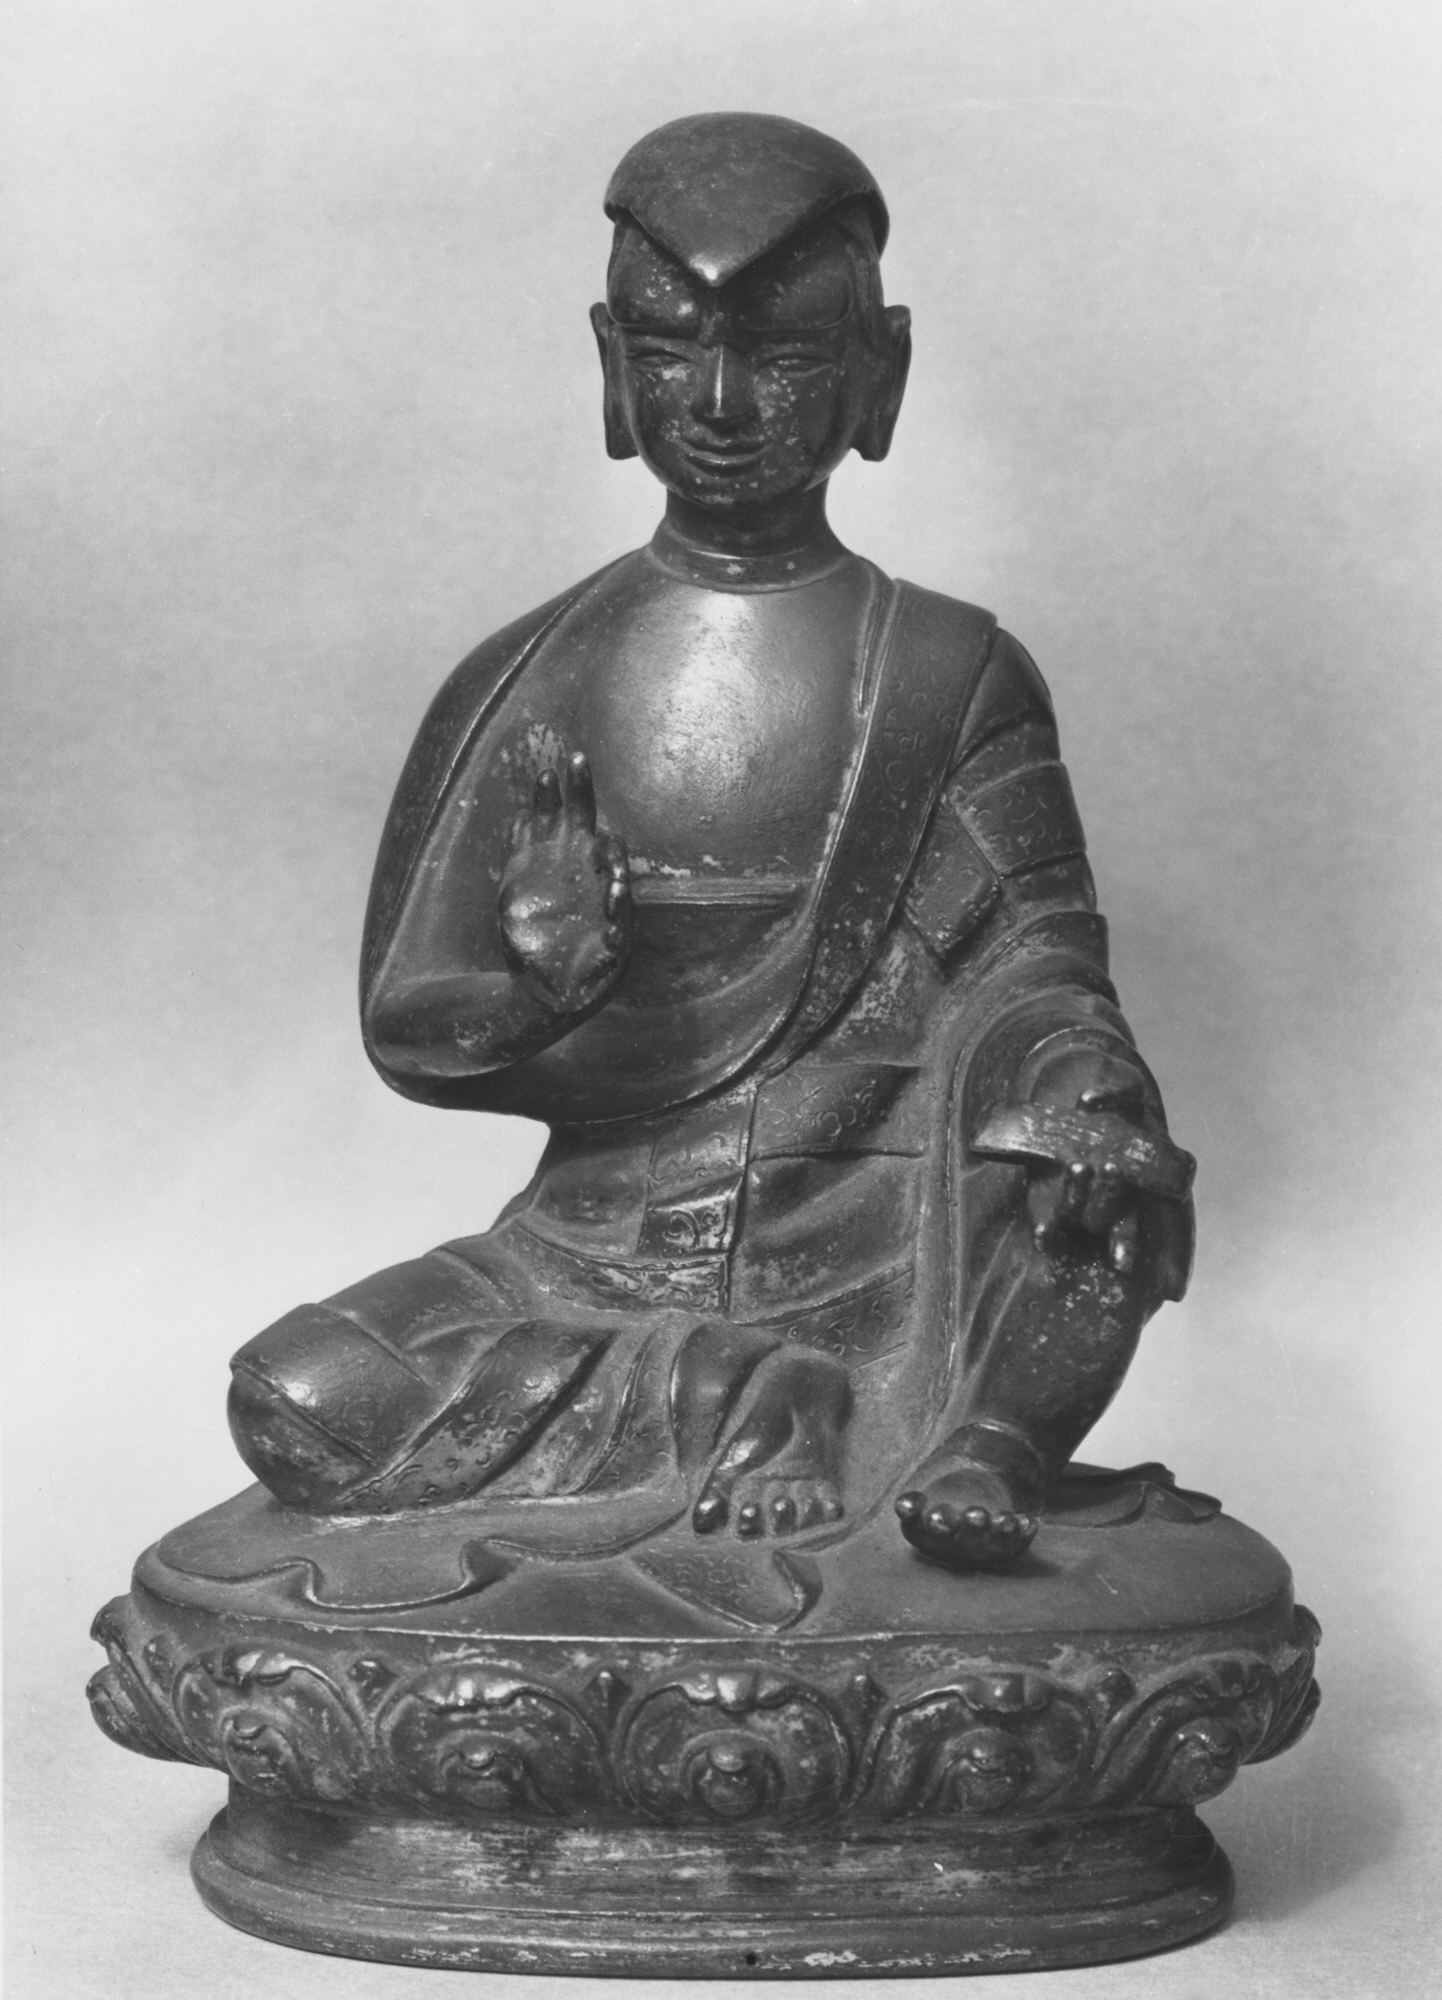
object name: figure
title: Seated Figure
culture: tibetan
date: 1601-1800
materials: gilt bronze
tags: men